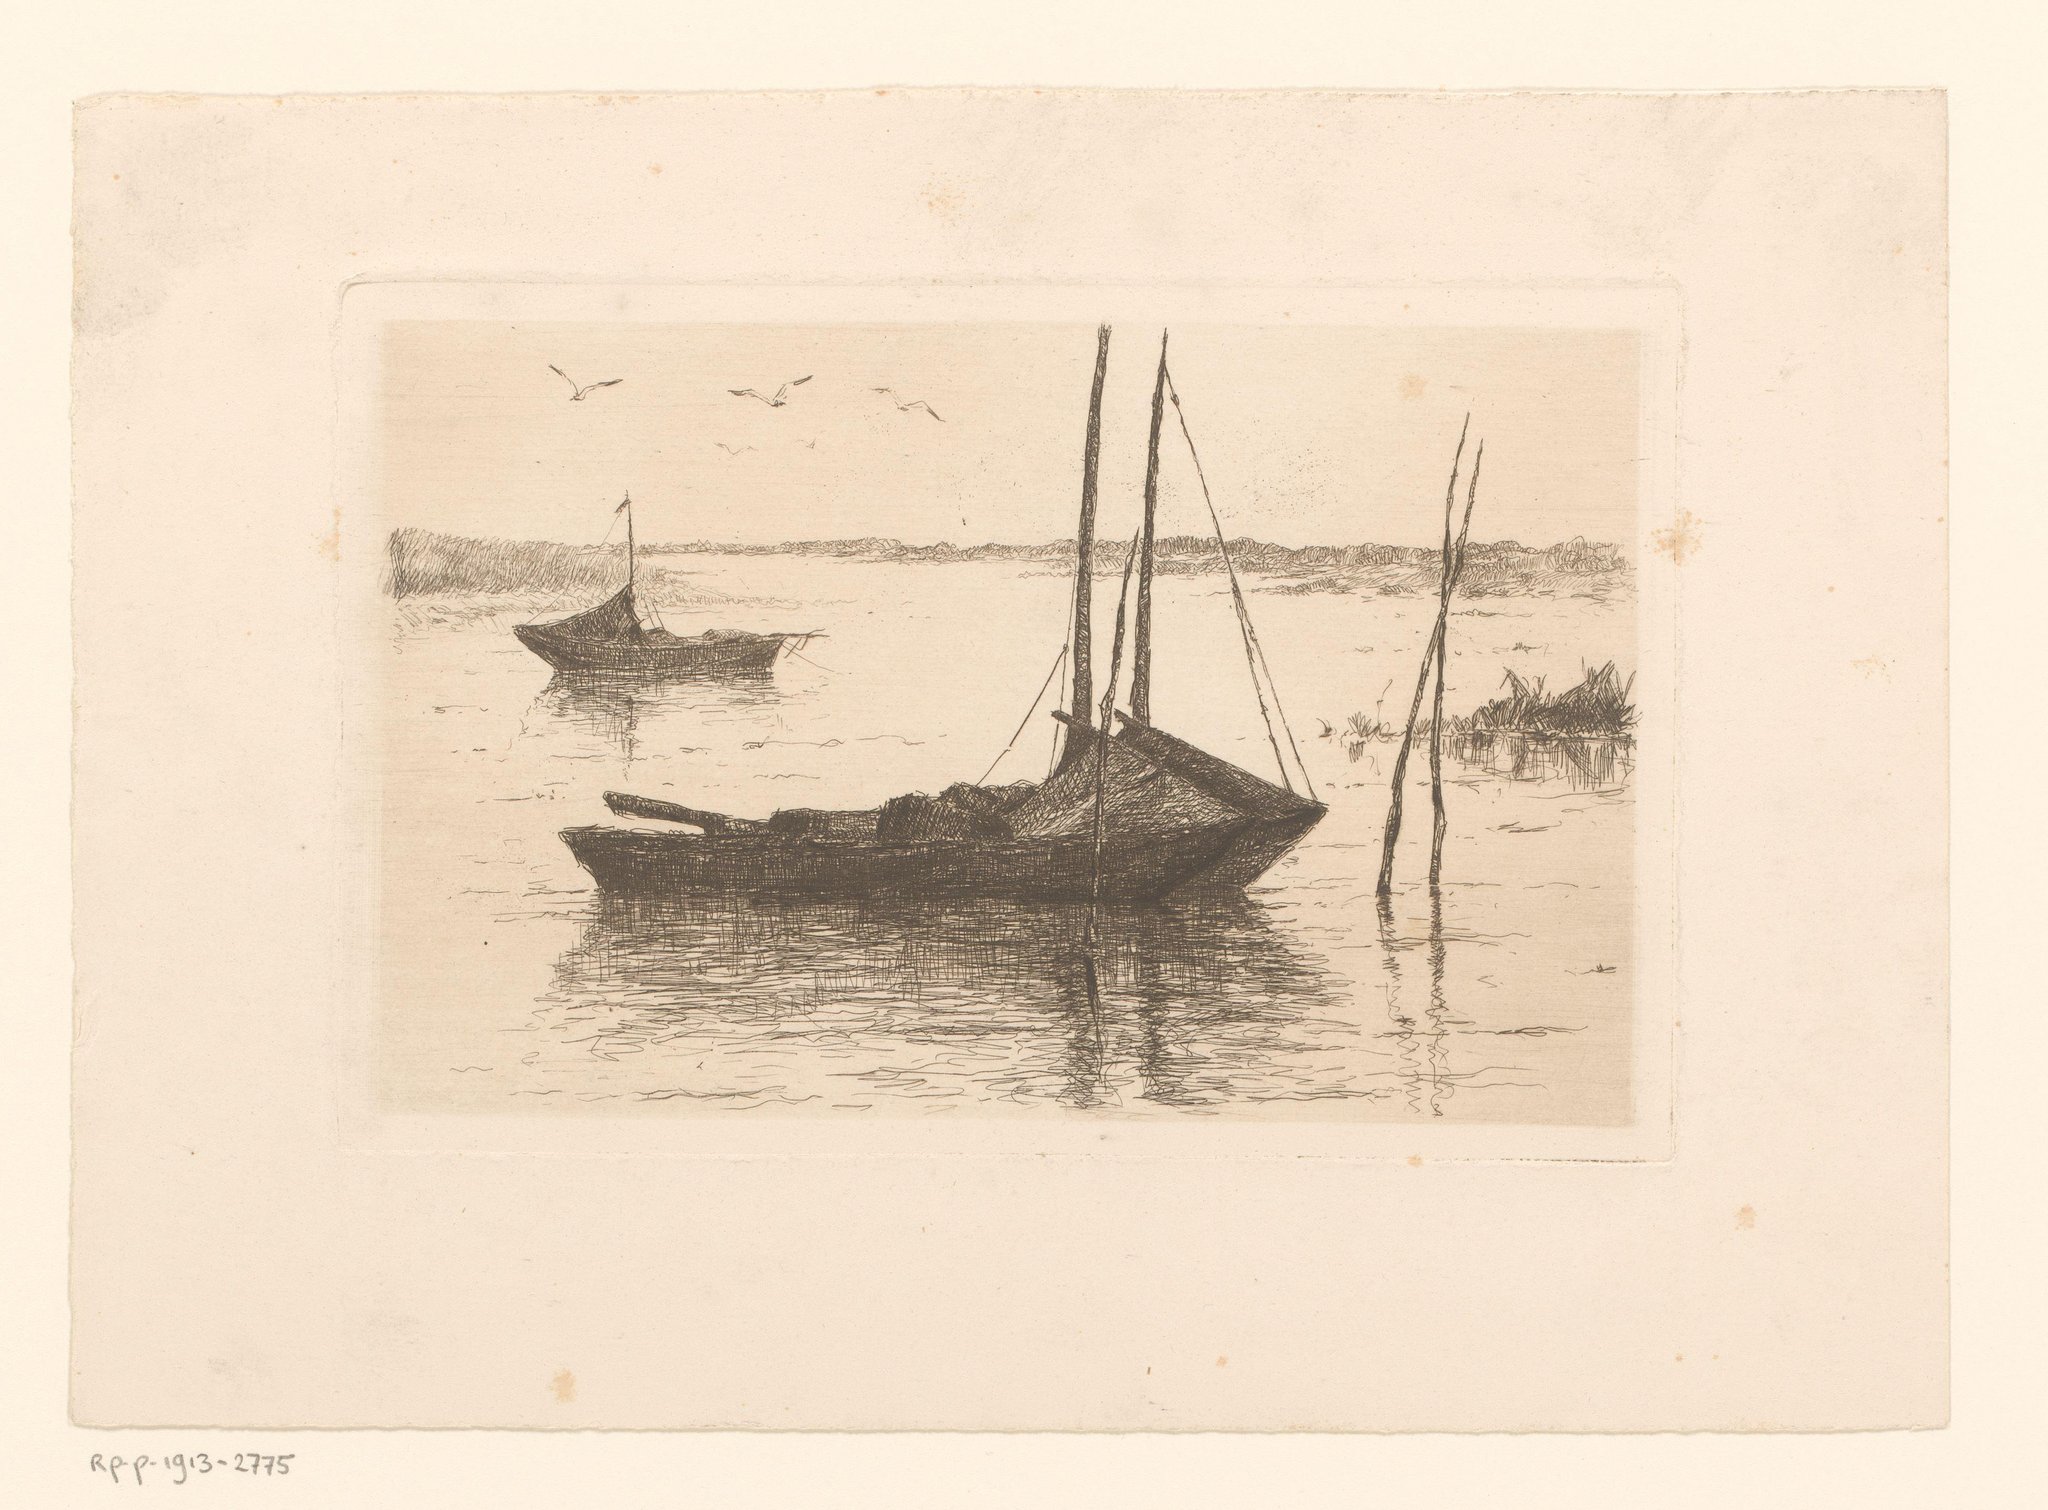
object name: print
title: Twee boten op het water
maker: henri rul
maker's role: print maker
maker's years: 1862-1942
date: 1872-1913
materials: paper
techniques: etching, intaglio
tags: landscapes with waters, waterscapes, seascapes (in the temperate zone), rowing-boat, canoe, etc.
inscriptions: collector's mark: Lugt 2228